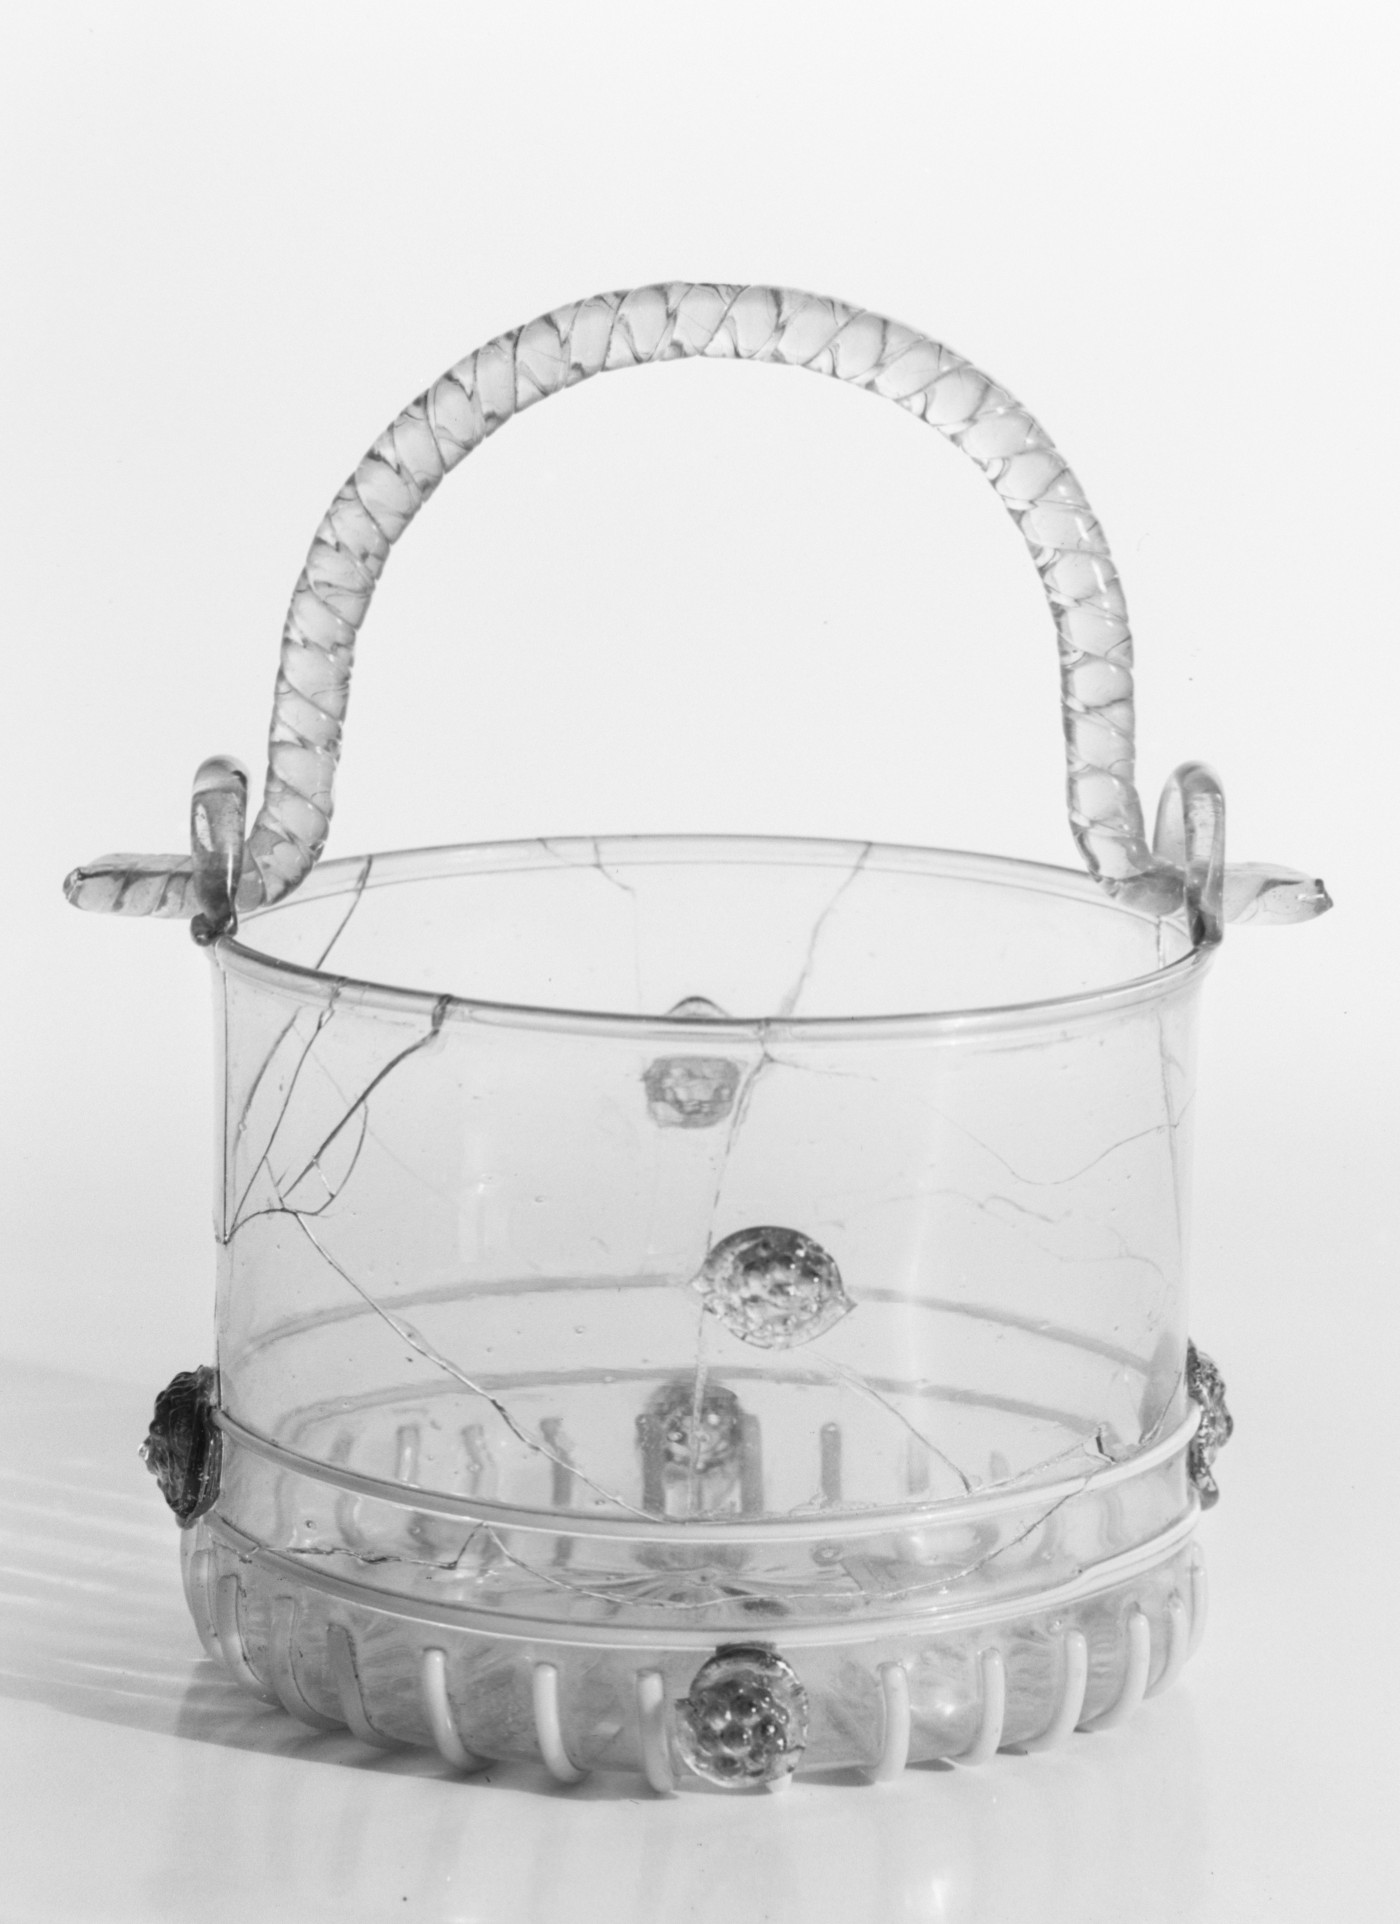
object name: bucket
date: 1501-1600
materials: glass